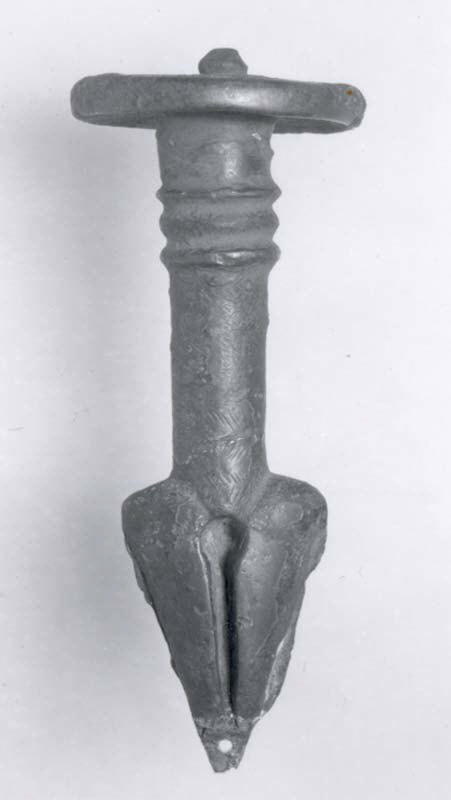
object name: dagger hilt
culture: iranian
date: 1333-668 BCE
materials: bronze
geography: northwestern iran